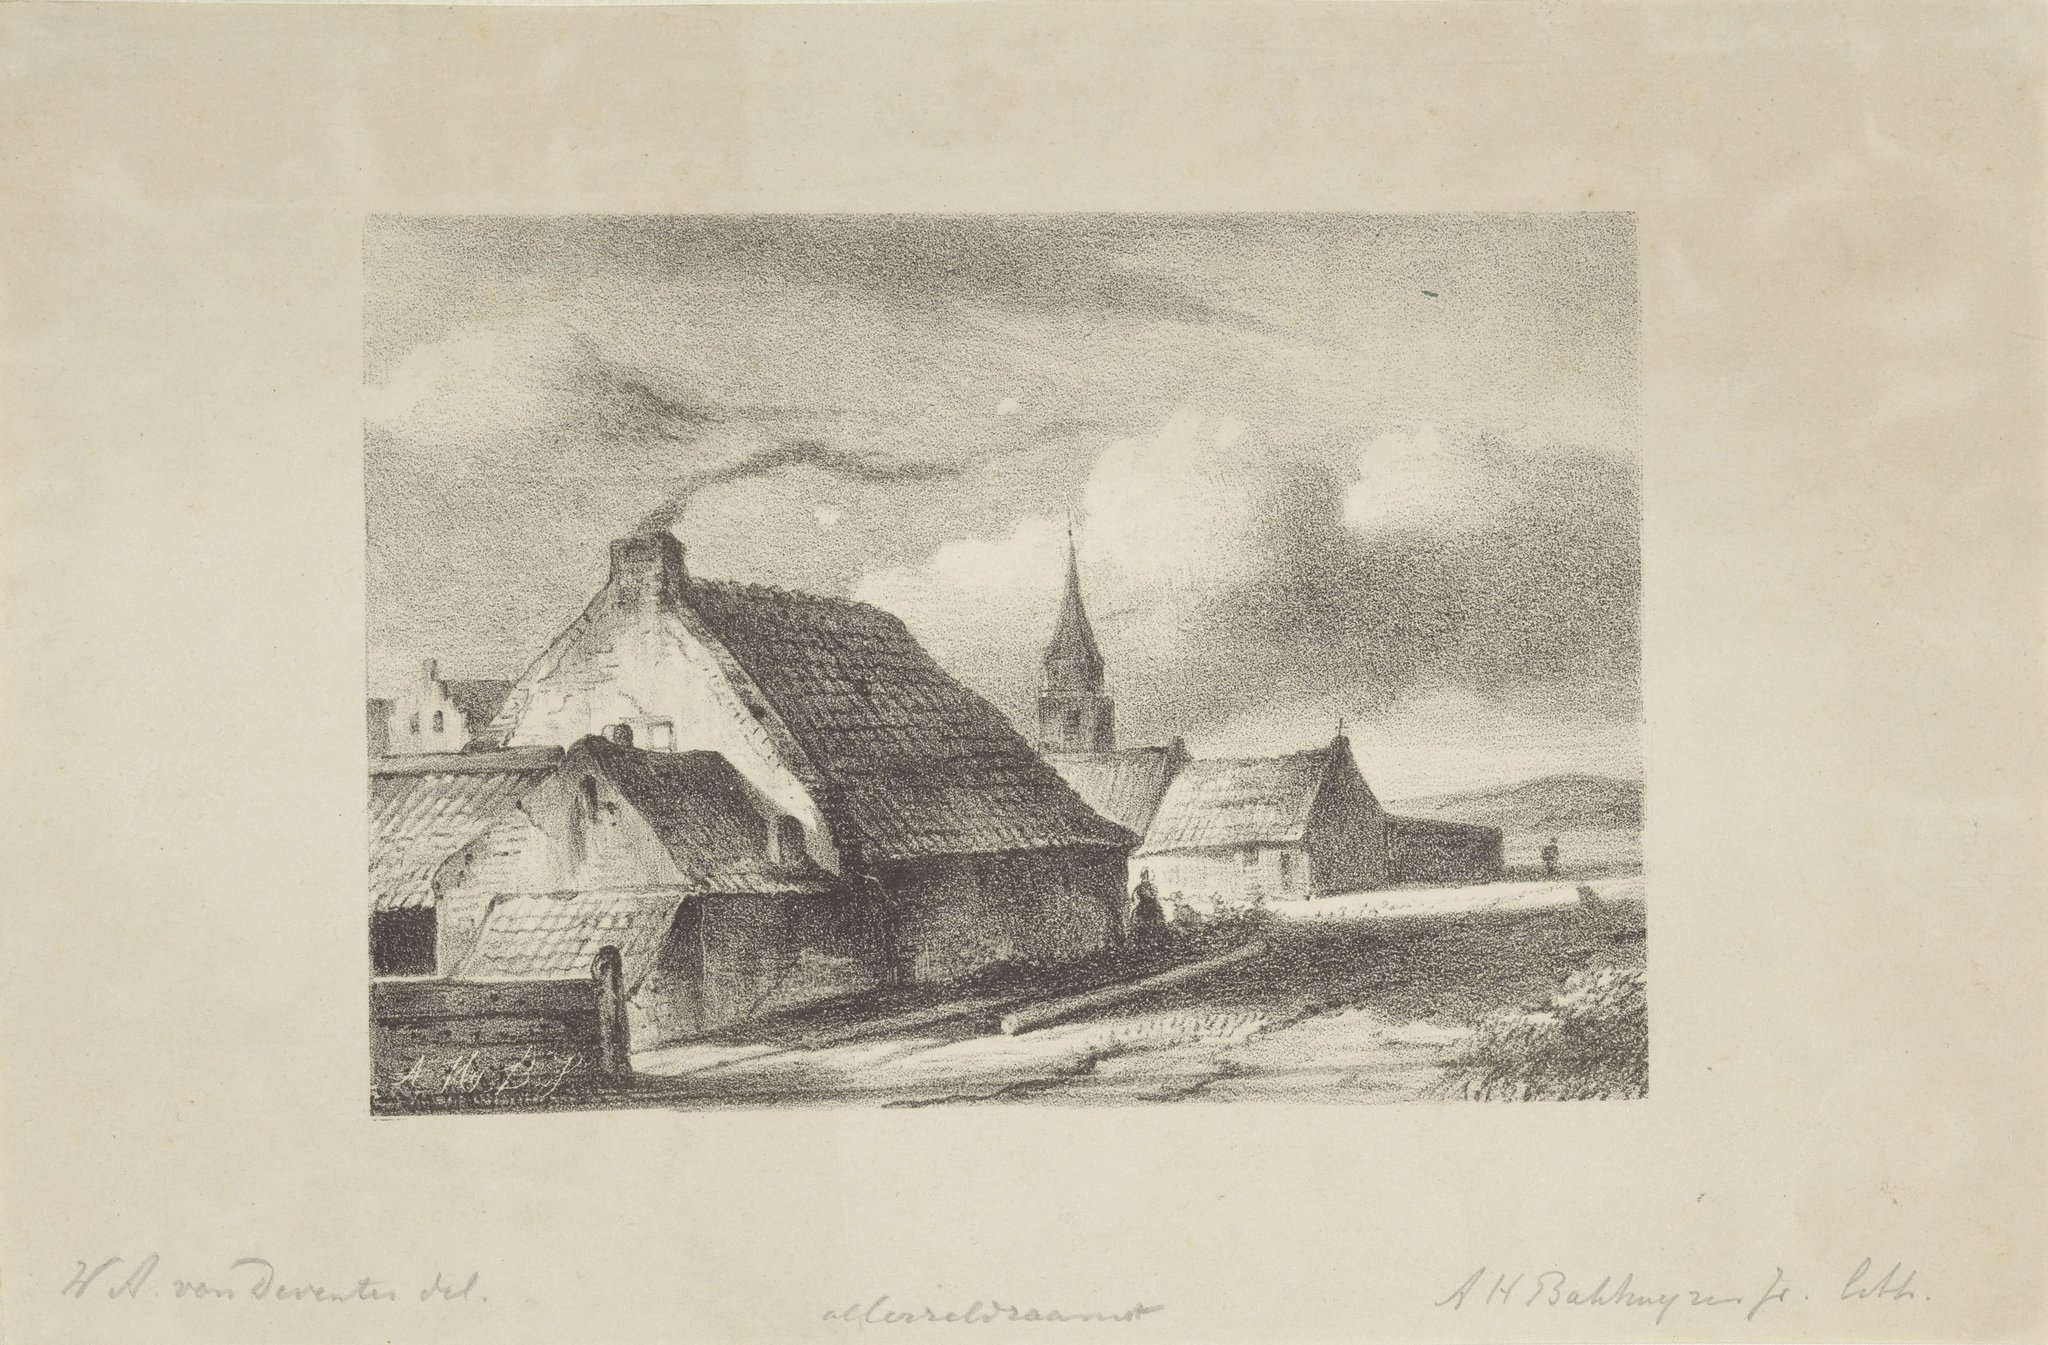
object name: print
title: Huizen en een kerktoren in Katwijk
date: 1836-1878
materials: paper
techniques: lithograph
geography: netherlands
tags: smoke-stack, church (exterior), street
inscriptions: inscription: ‘W. A. van Deventer’, collector's mark: Lugt 2228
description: Aan een landweg staan huizen met daarachter een kerk. Uit een van de schoorstenen stijgt rook op. Op de weg lopen enkele figuren.